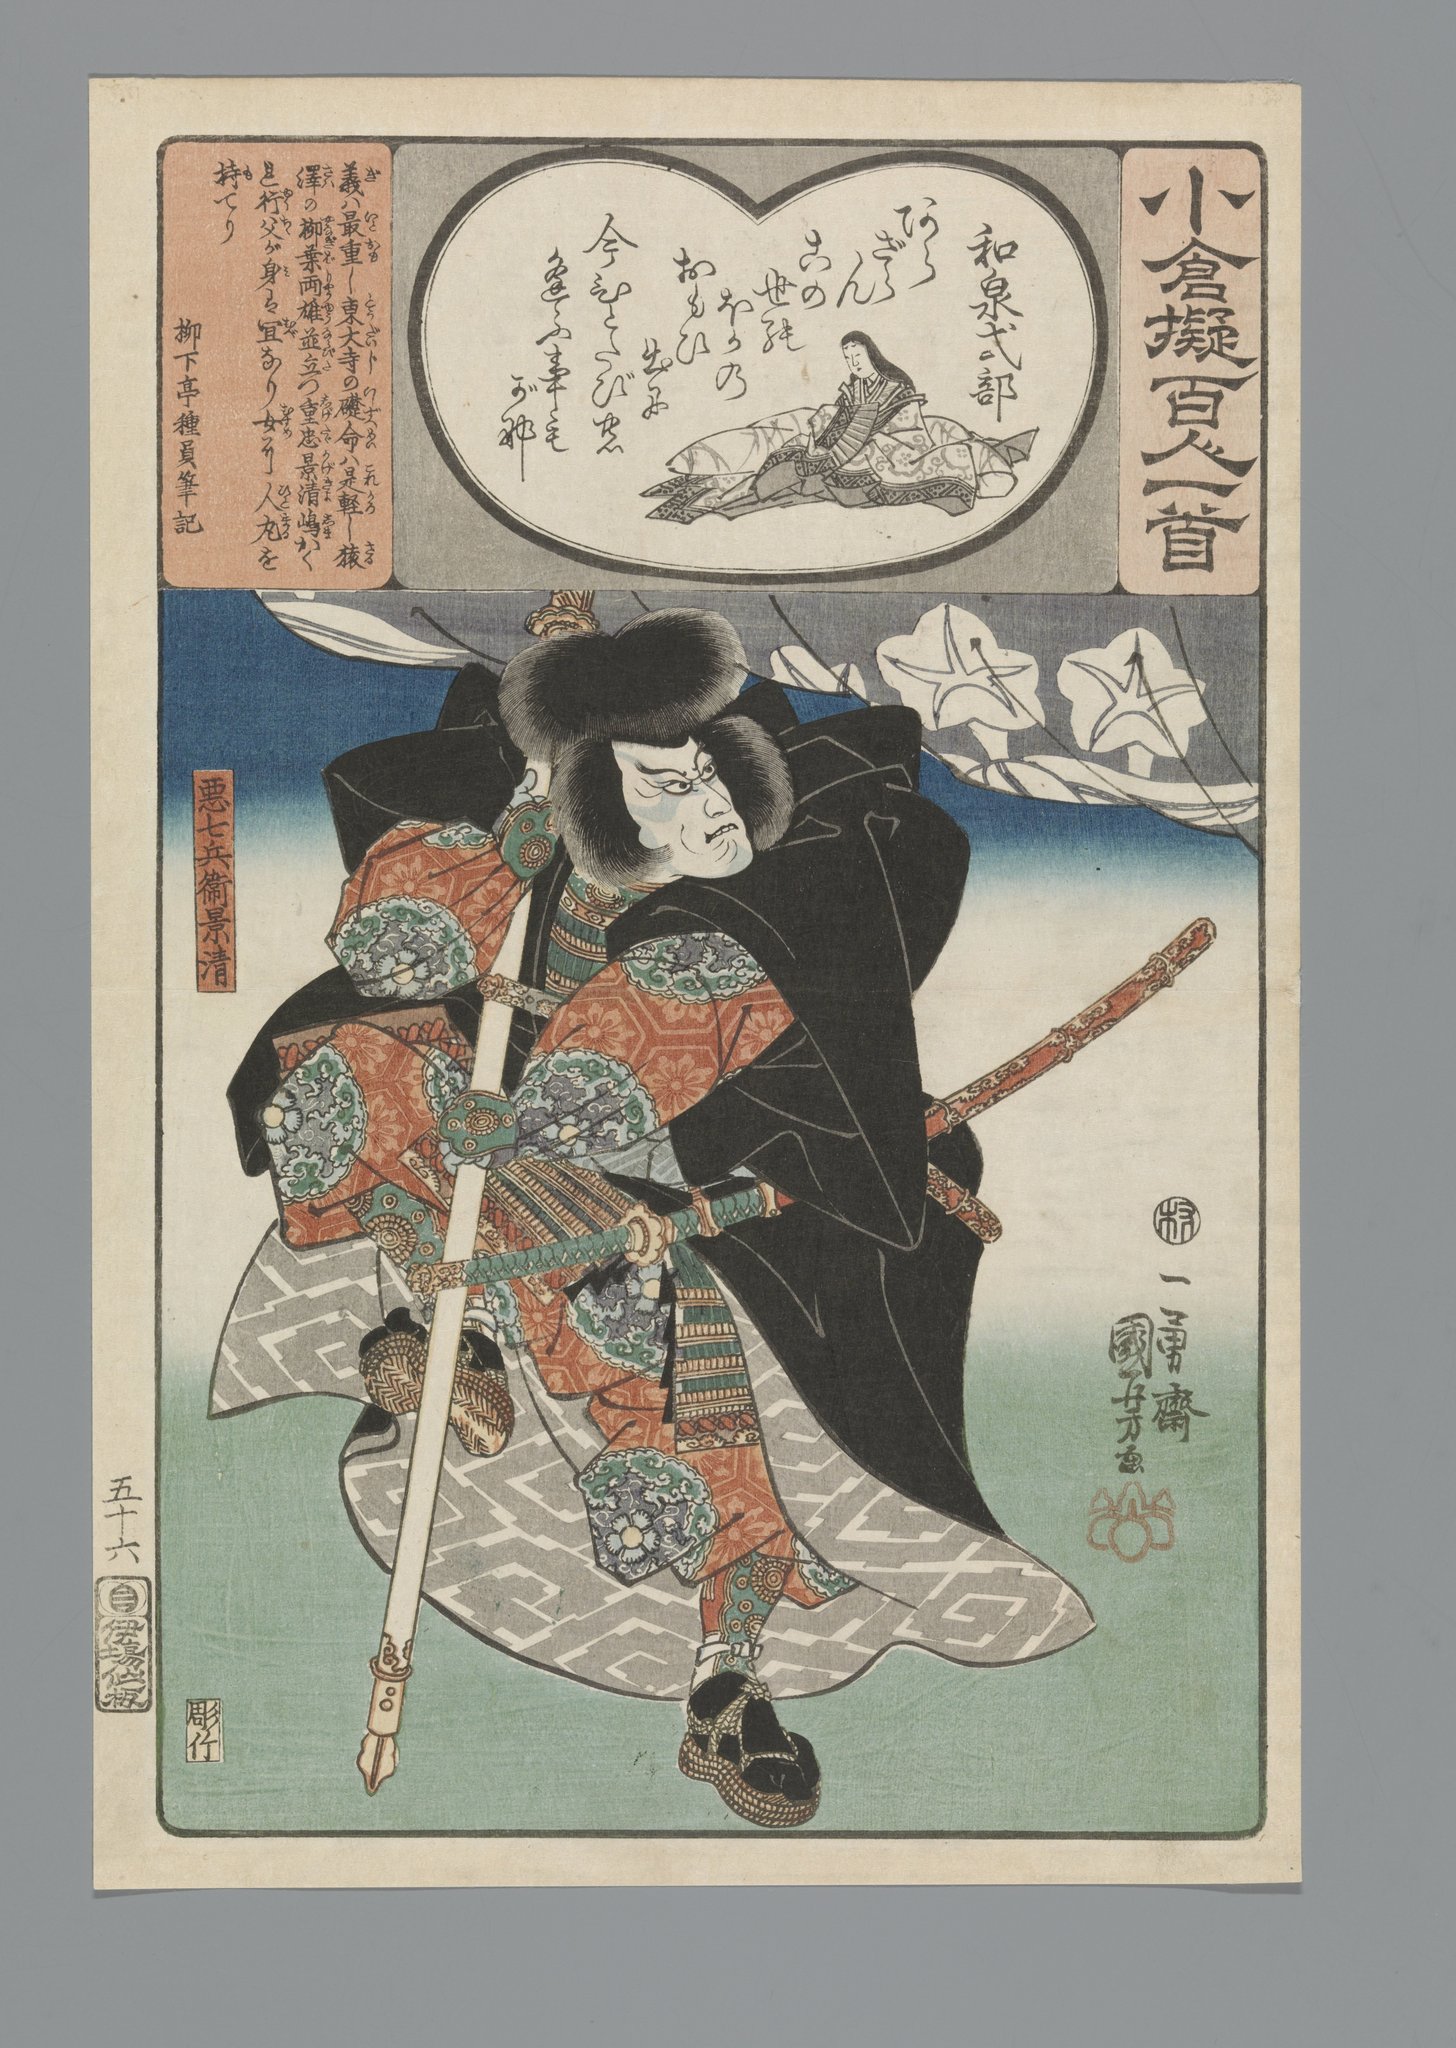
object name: print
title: Ogura Imitation of the One Hundred Poems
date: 1843-1845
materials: paper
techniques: woodcut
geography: japan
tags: dancing, hacking and thrusting weapons: sword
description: Akushichibyôe Kagekiyo dansend met zwaard en hellebaard. Op het blauwe doek op de achtergrond het familiewapen van Kegekiyo`s vijand, Yoritomo Minamoto. Scene uit een kabukitoneelstuk. Gedicht door Izumi Shikibu.